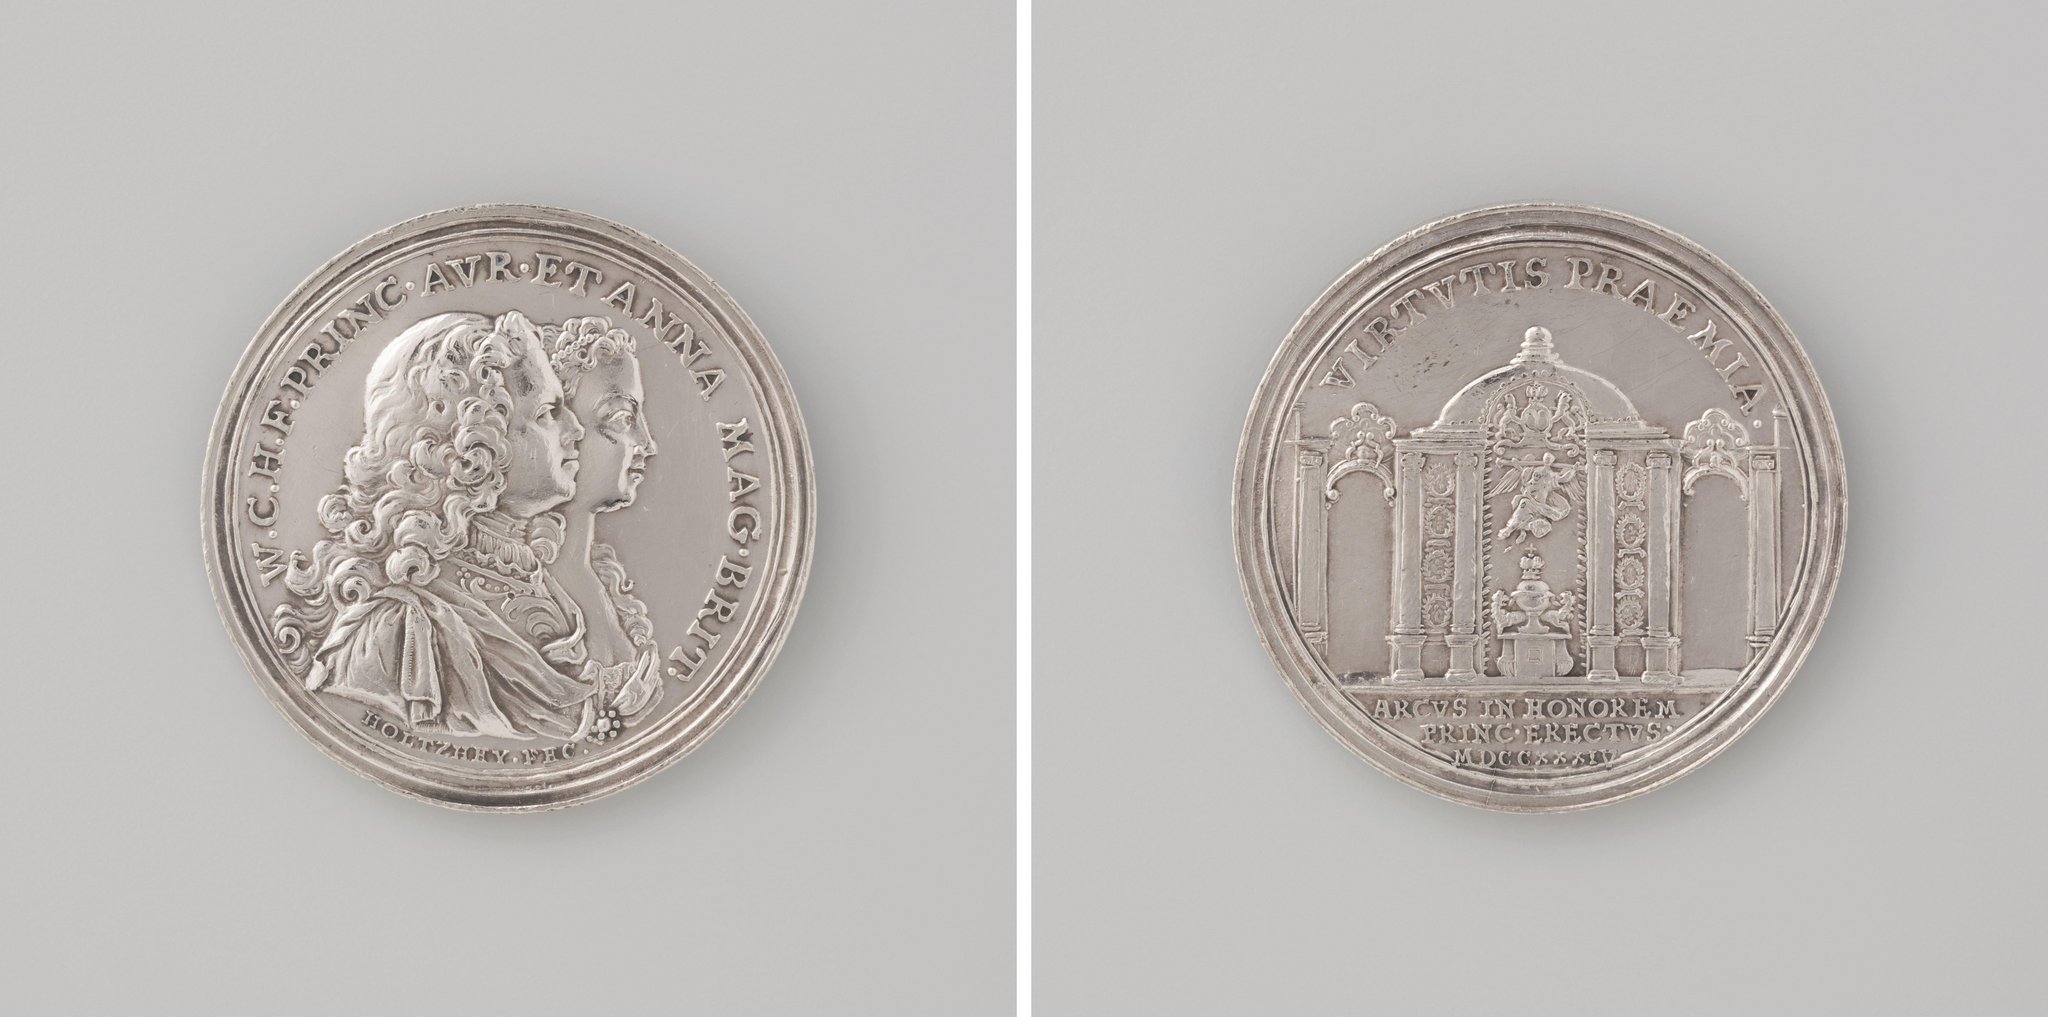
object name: history medal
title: Aankomst van Willem IV en prinses Anna van Engeland te Leeuwarden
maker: martinus holtzhey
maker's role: medailleur, muntmaker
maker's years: 1697-1764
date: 1734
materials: silver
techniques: striking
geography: amsterdam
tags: willem iv (prins van oranje-nassau), the hague, anna van hannover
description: Zilveren penning. Voorzijde: borststuk man en vrouw binnen omschrift. Keerzijde: genius van Friesland met scheepsroer en wapenschild begroet prins en prinses, afgebeeld als Mars en Venus, die elkaar bij de hand houden, rechts van hen wapenschild binnen omschrift; afsnede: opsch